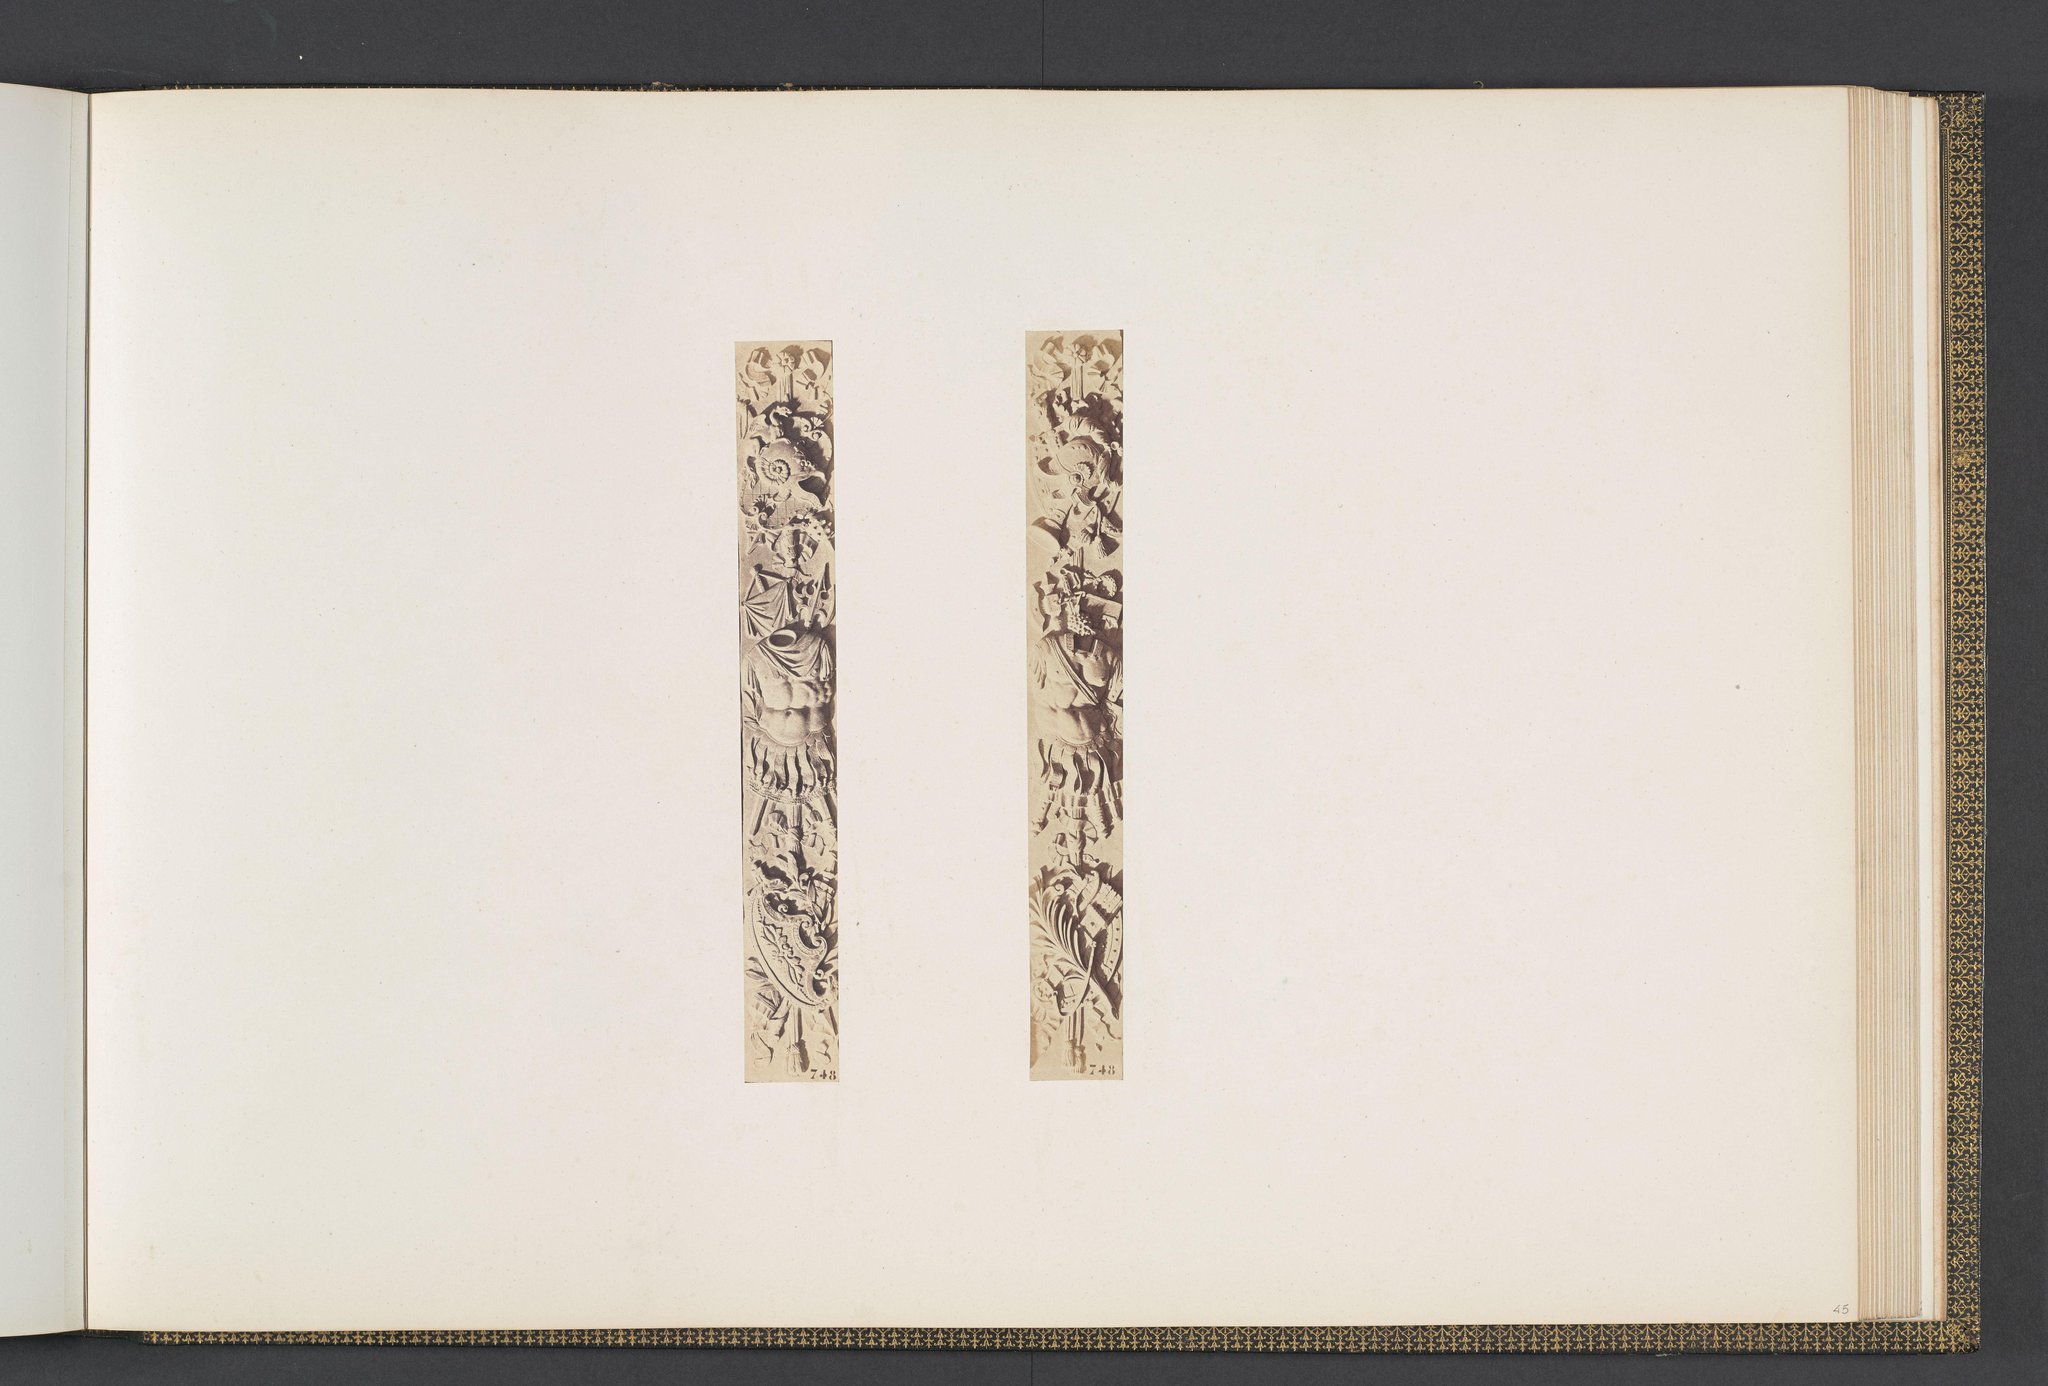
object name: photograph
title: Gipsmodellen voor gevelversieringen aan de Cour Lefuel van het Palais du Louvre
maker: édouard denis baldus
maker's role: fotograaf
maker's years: 1813-1889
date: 1855-1857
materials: paper, photographic support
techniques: salted paper print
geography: paris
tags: permanent exhibition, museum, ornamenting, decorating ~ applied arts, paris, tuileries palace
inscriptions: number: ‘748 (beide)’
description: Onderdeel van Réunion des Tuileries au Louvre 1852-1857, album 3.